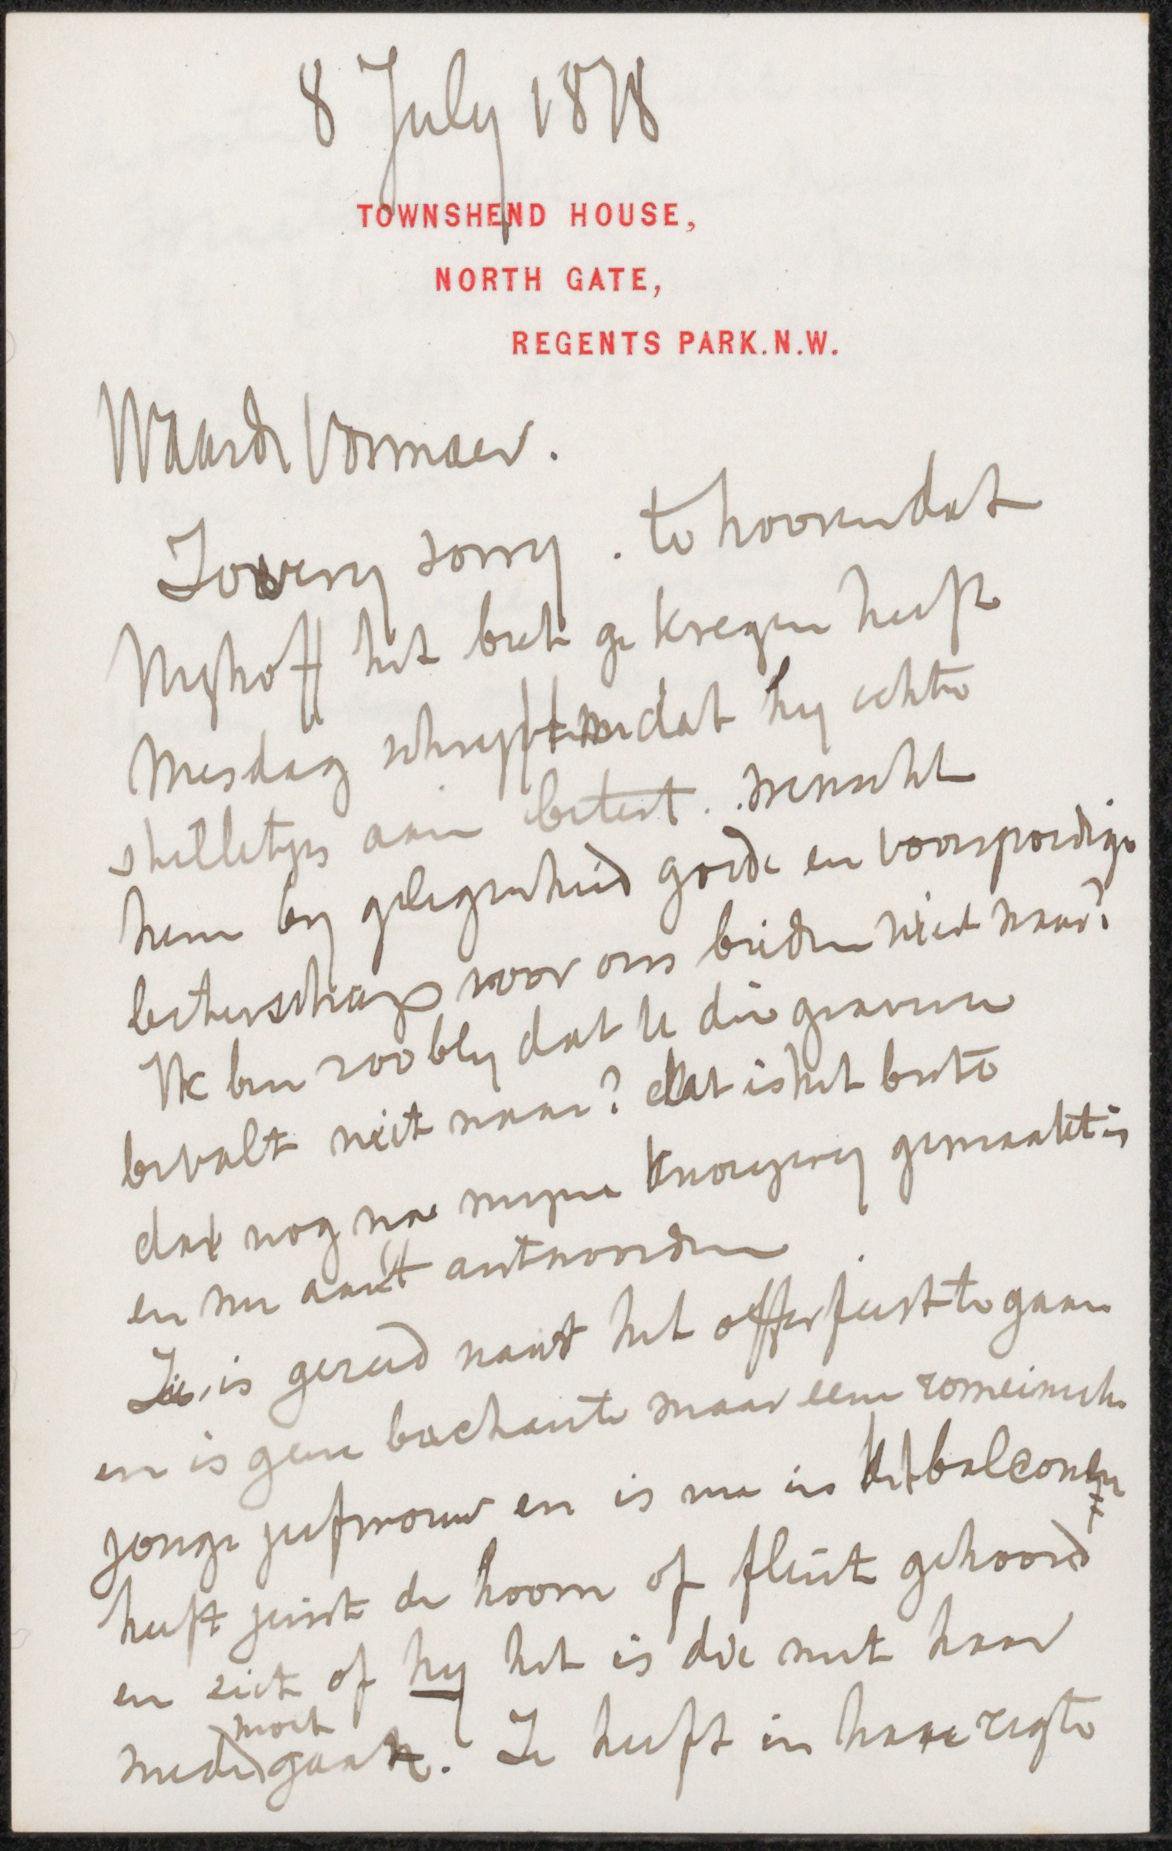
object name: letter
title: Brief aan Carel Vosmaer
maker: lourens alma tadema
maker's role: draughtsman, print maker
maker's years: 1836-1912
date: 1878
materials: ink, paper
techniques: pen, printing, writing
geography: london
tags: painter, jozef israëls, hendrik willem mesdag, carel vosmaer, arnhem, the hague, publisher, martinus nijhoff, distribution of awards ~ art contest, photography, cinematography, the graphic arts, painting (including book-illumination, miniature-painting), exhibition ~ art